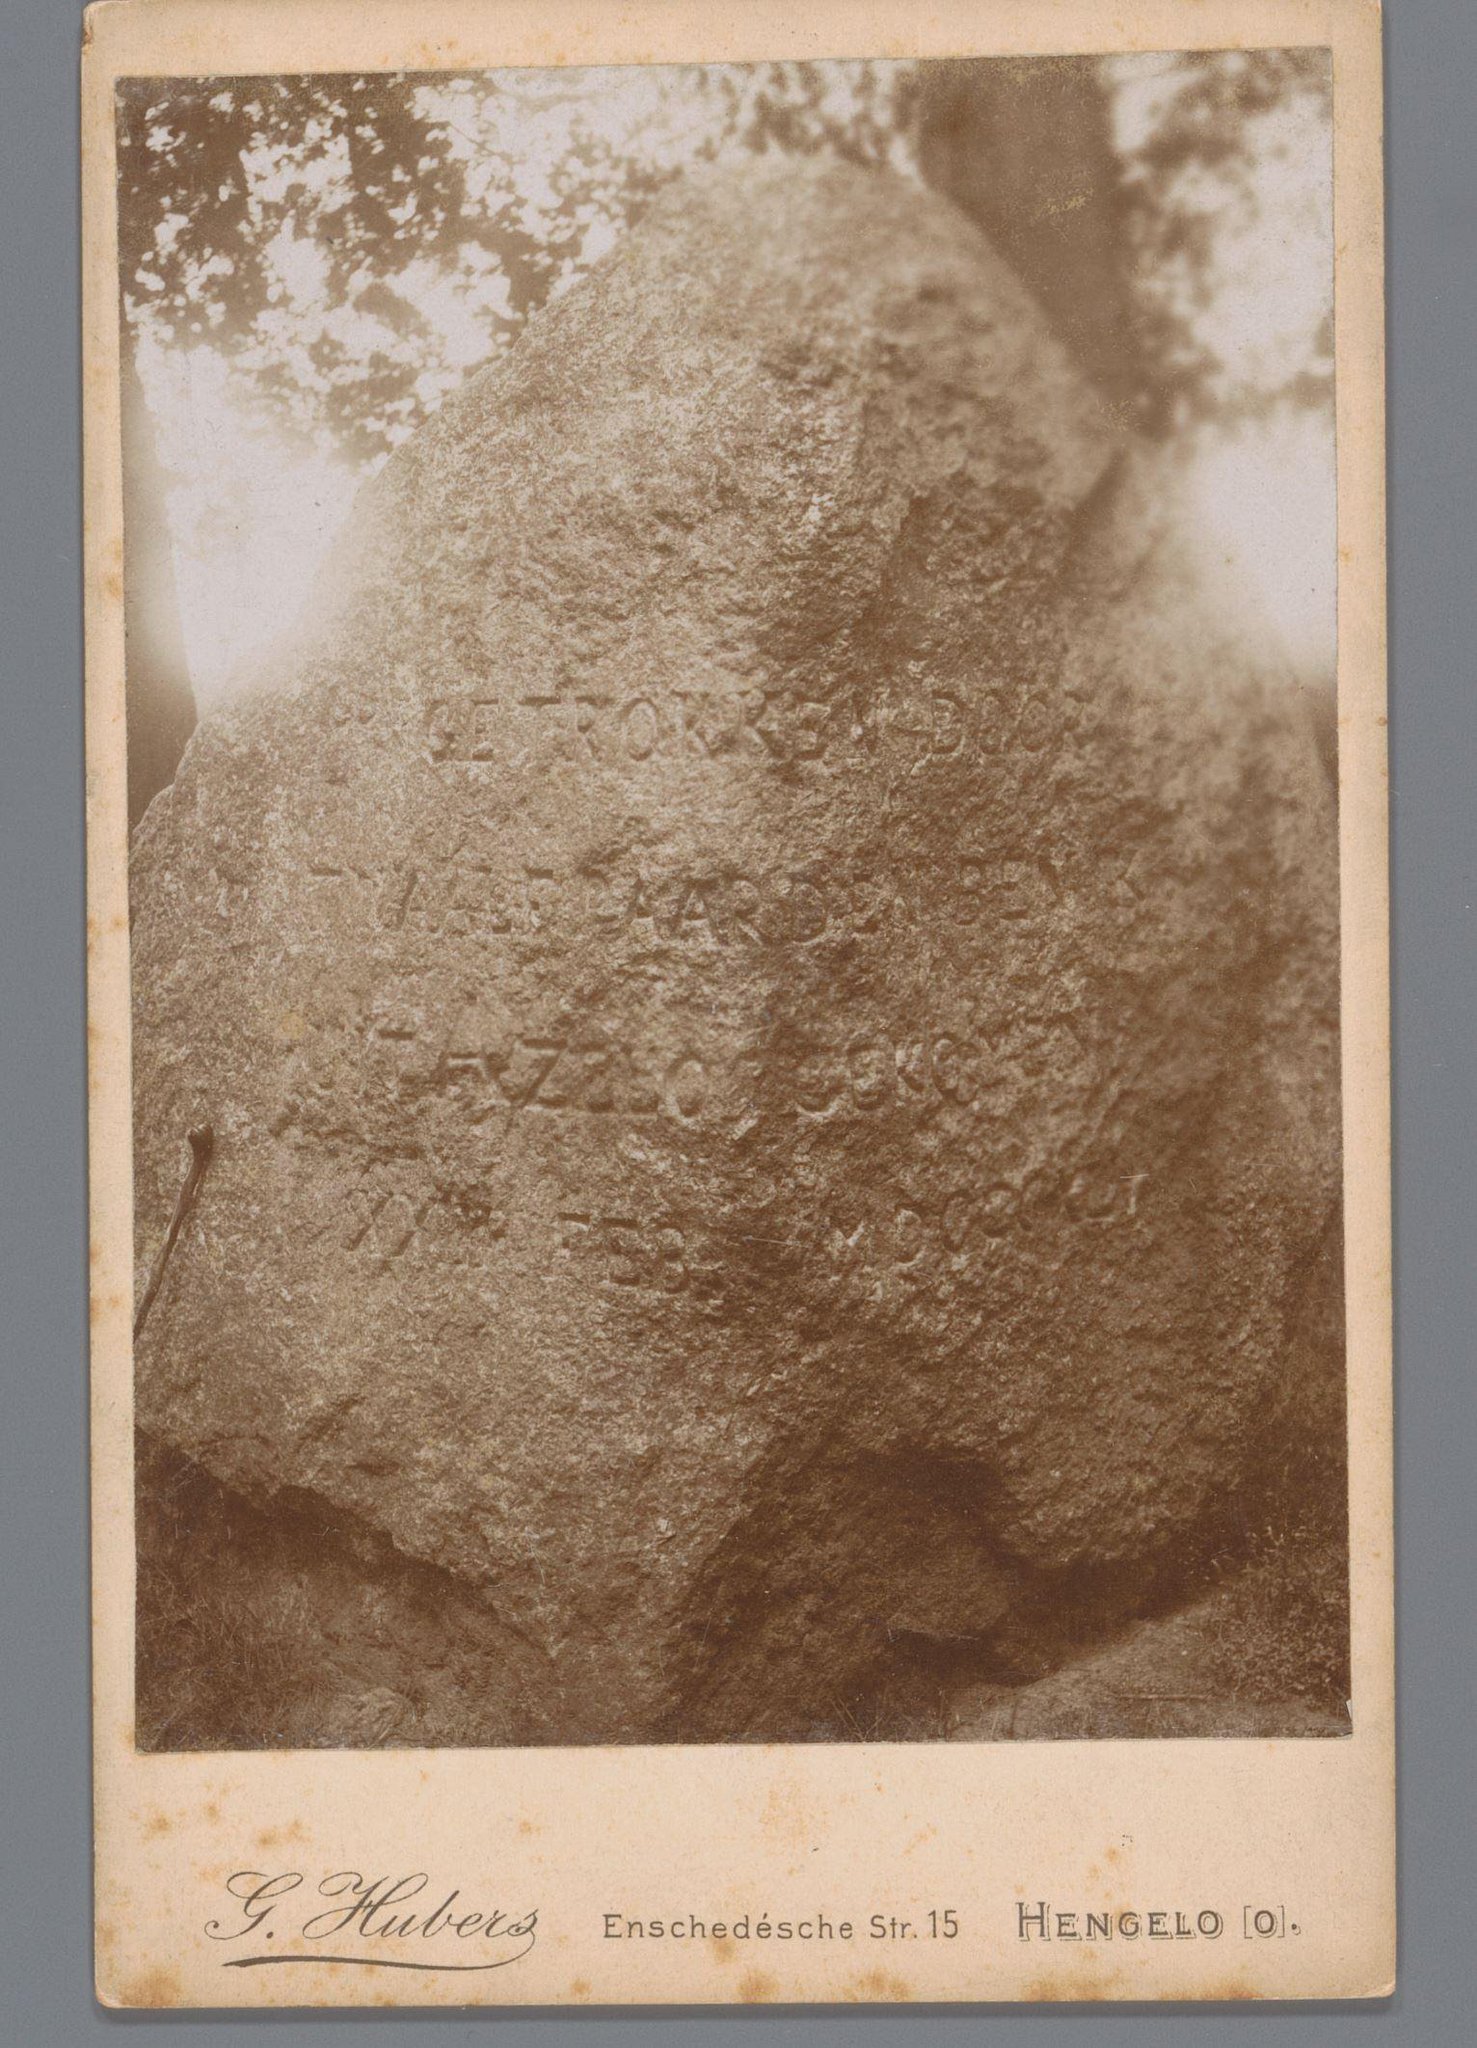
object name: photograph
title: Rotsblok met opschrift, vermoedelijk een gedenksteen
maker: gerrit hubers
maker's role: fotograaf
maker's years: 1863-1927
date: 1894-1927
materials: cardboard, photographic support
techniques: collodion silver print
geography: netherlands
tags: other memorial structures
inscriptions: retailer's mark: ‘Boekhandel-Binderij/ E. Broekhuis/ Hengelo (O.)’, annotation: ‘G. Hubers/ Enschedésche Str. 15/ Hengelo [O].’, number: ‘220’